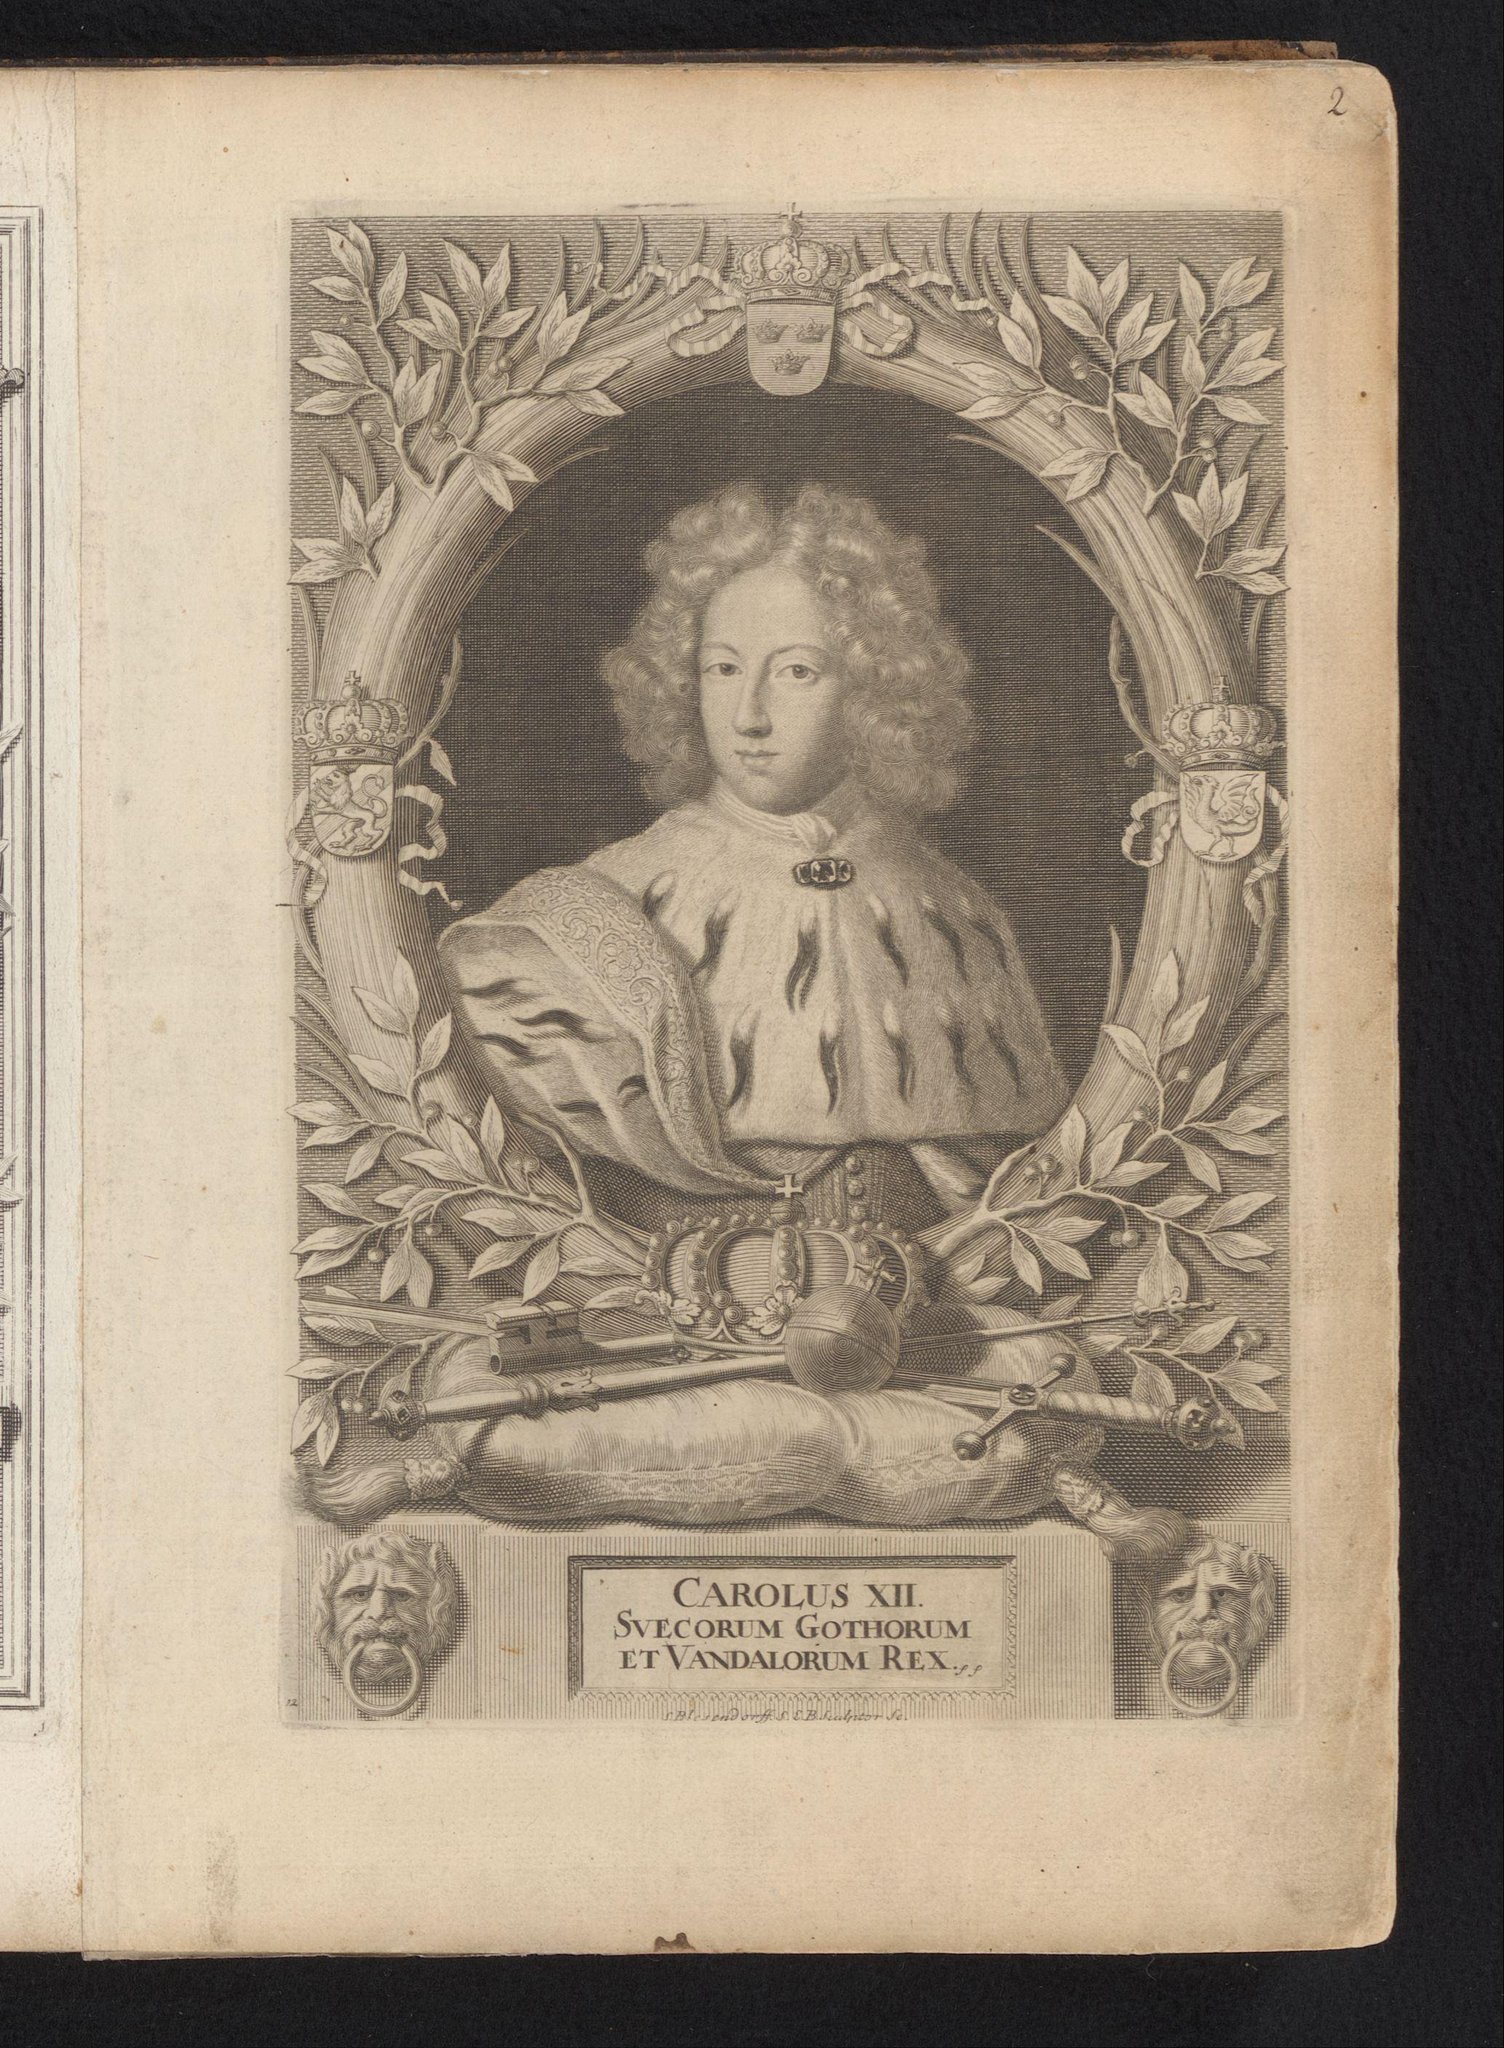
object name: album leaf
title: Carolus XII, Suecorum Gothorum Et Vandalorum Rex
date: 1698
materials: paper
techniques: engraving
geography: germany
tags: fredrikshald, koning, karel xii (koning van zweden)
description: Kungliga Biblioteket, 'Suecia': http://www.kb.se/samlingarna/Kartor-bilder/Suecia-antiqua/ (geraadpleegd november 2016).